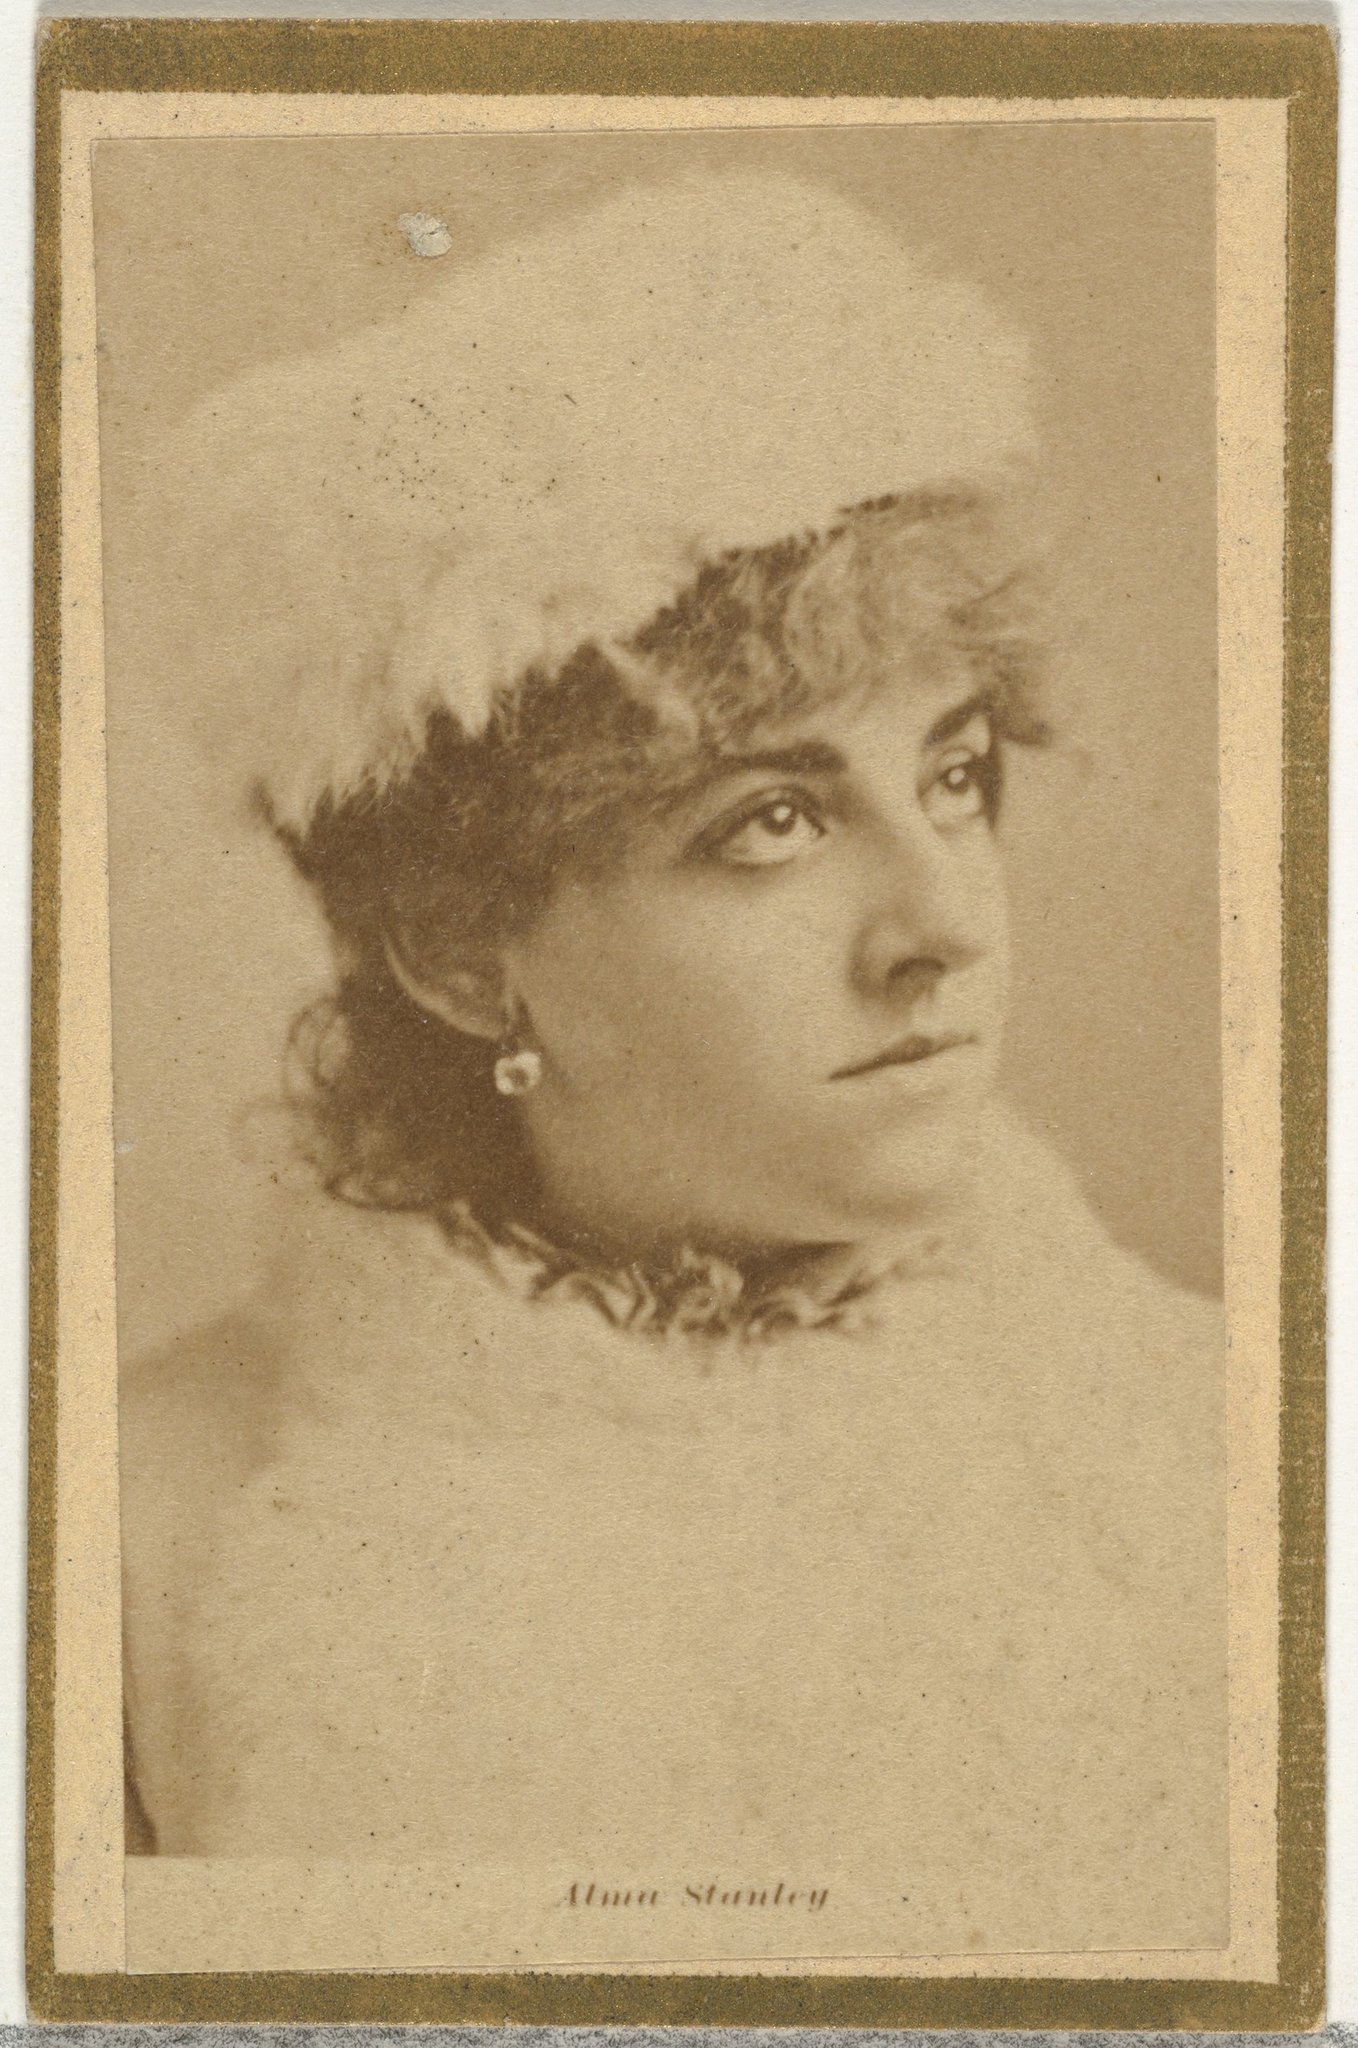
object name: photograph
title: Alma Stanley, from the Actresses and Celebrities series (N60, Type 2) promoting Little Beauties Cigarettes for Allen & Ginter brand tobacco products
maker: allen & ginter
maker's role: publisher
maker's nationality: american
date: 1887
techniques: albumen silver print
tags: portraits,women,actresses